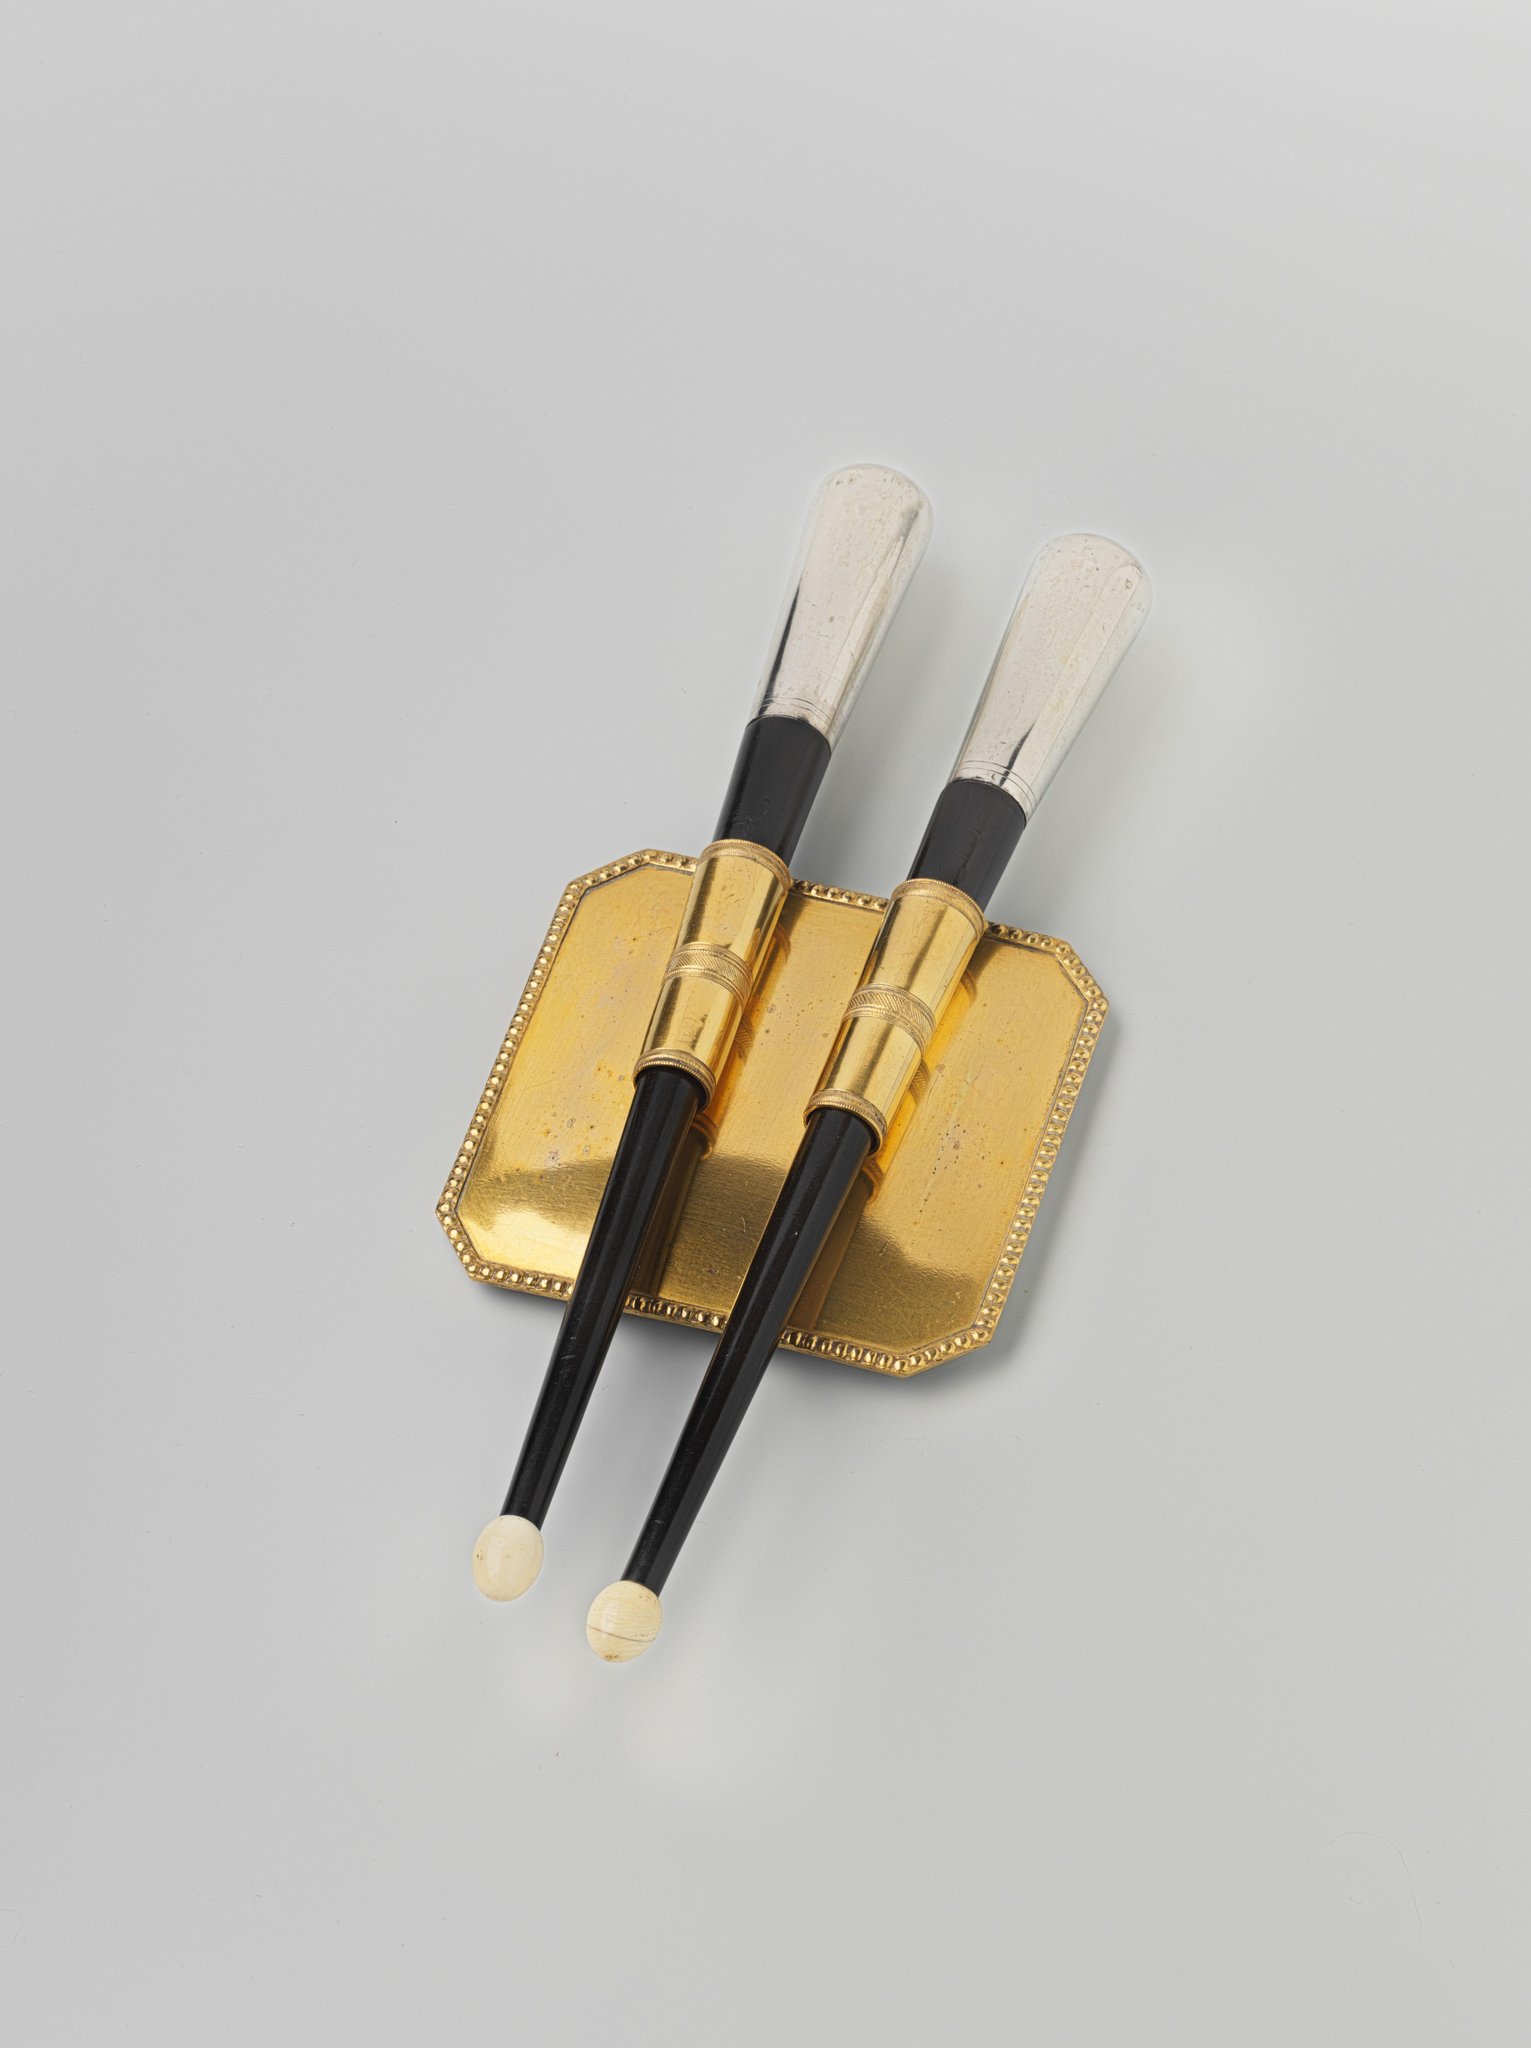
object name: stick plate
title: Stokplaat van verguld koper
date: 1823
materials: copper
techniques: gilding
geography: netherlands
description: Stokplaat voor een slagband van een tamboer-majoor.